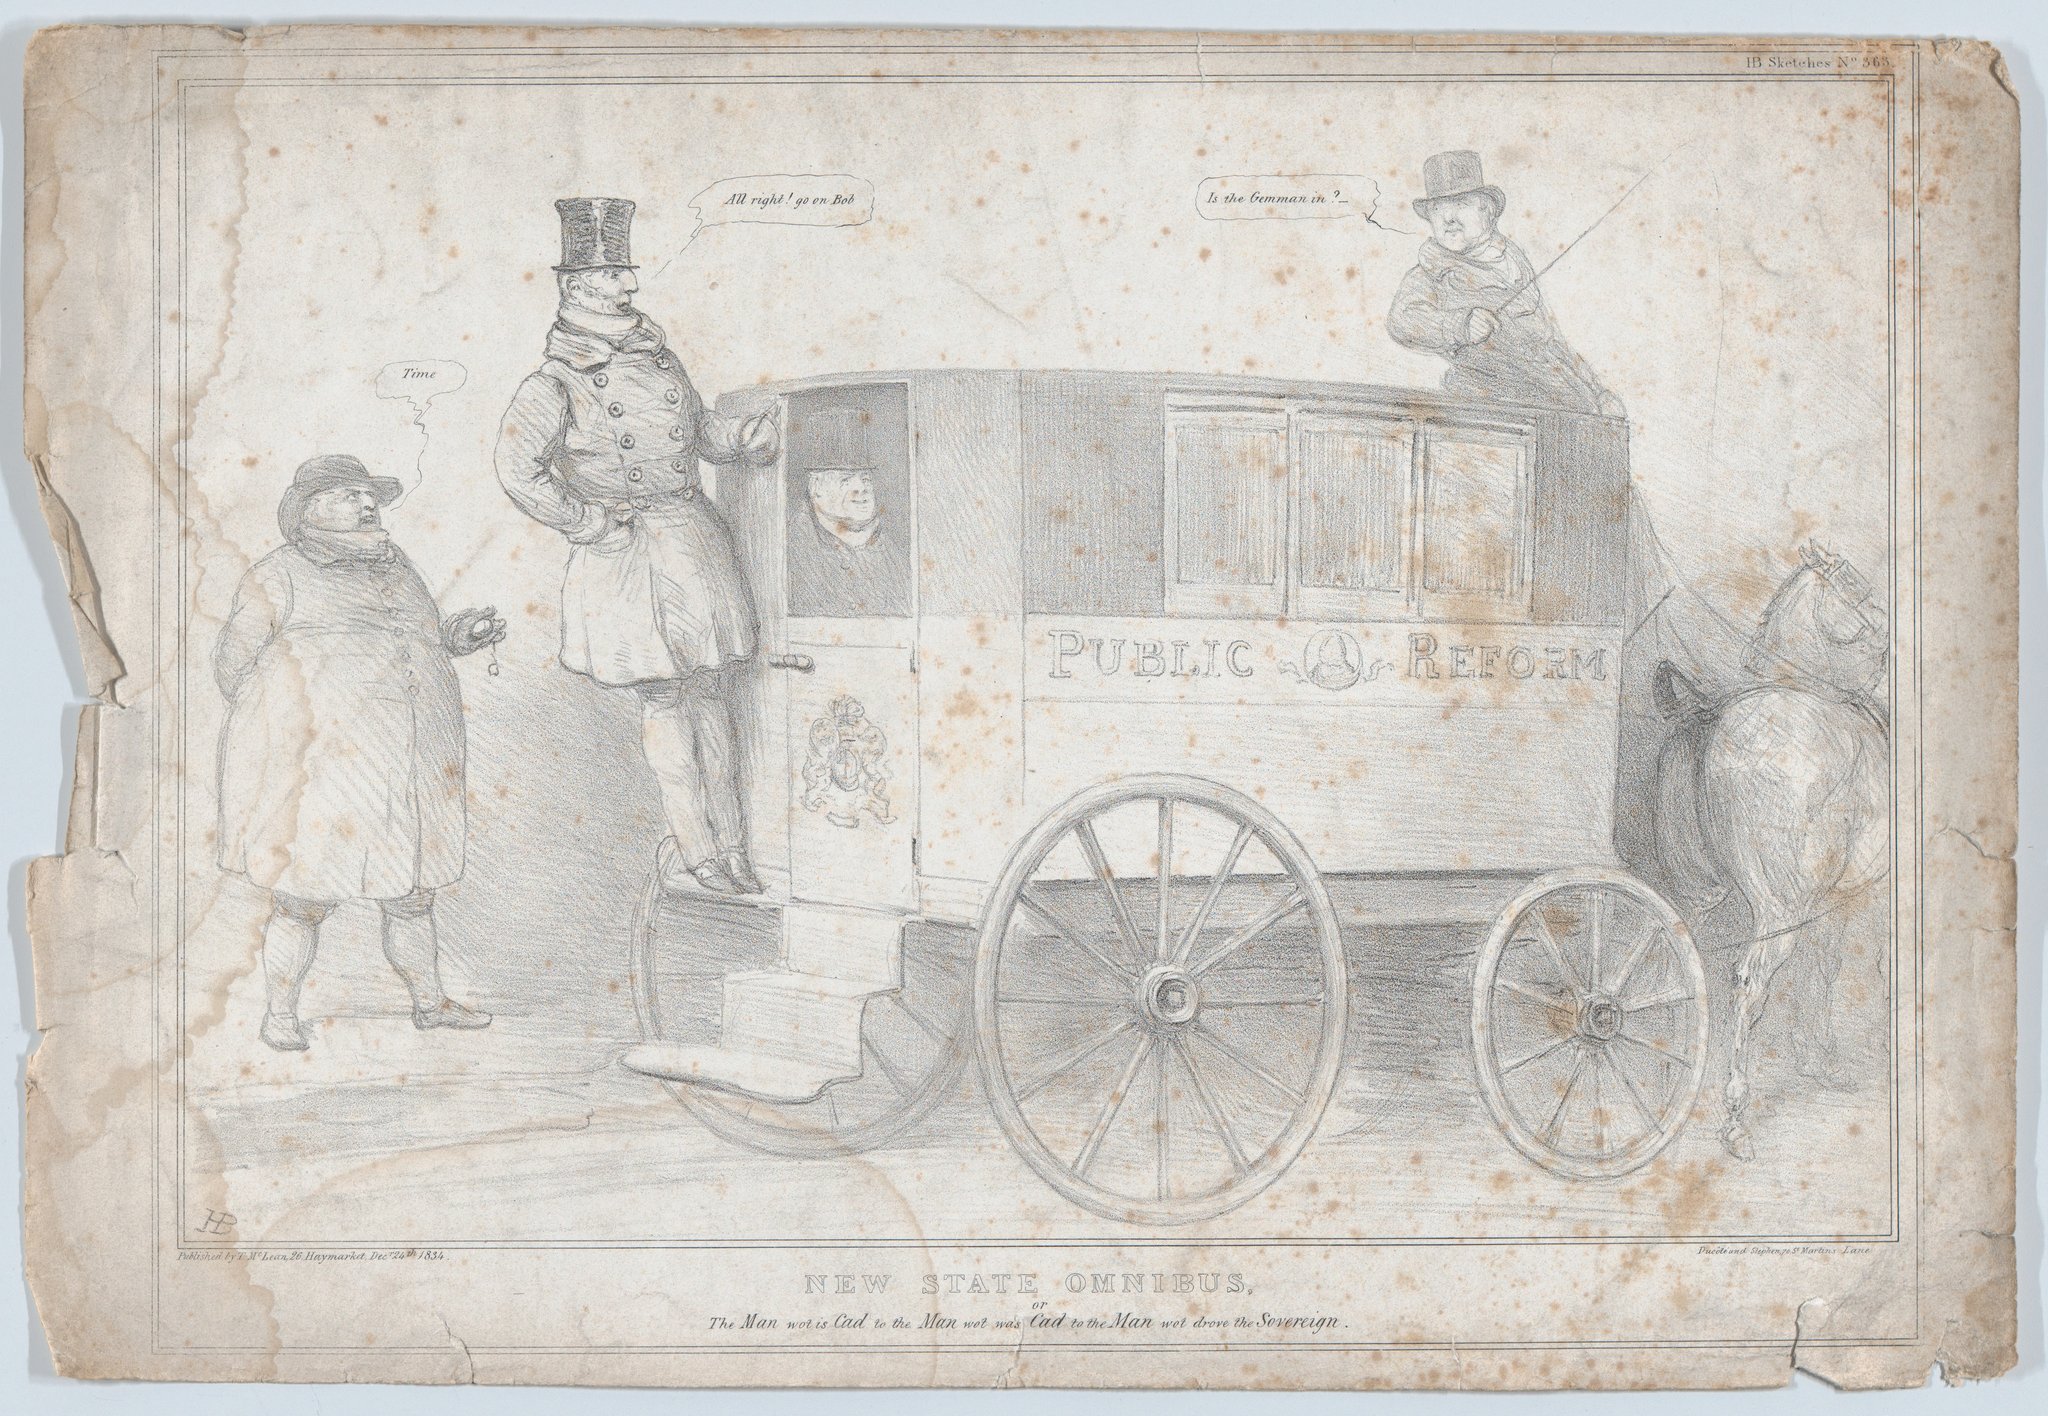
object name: print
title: New State Omnibus, or, The Man wot is Cad to the Man wot was Cad to the Man wot drove the Sovereign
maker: john doyle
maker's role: artist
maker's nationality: irish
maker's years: 1797-1868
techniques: lithograph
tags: men,carriages